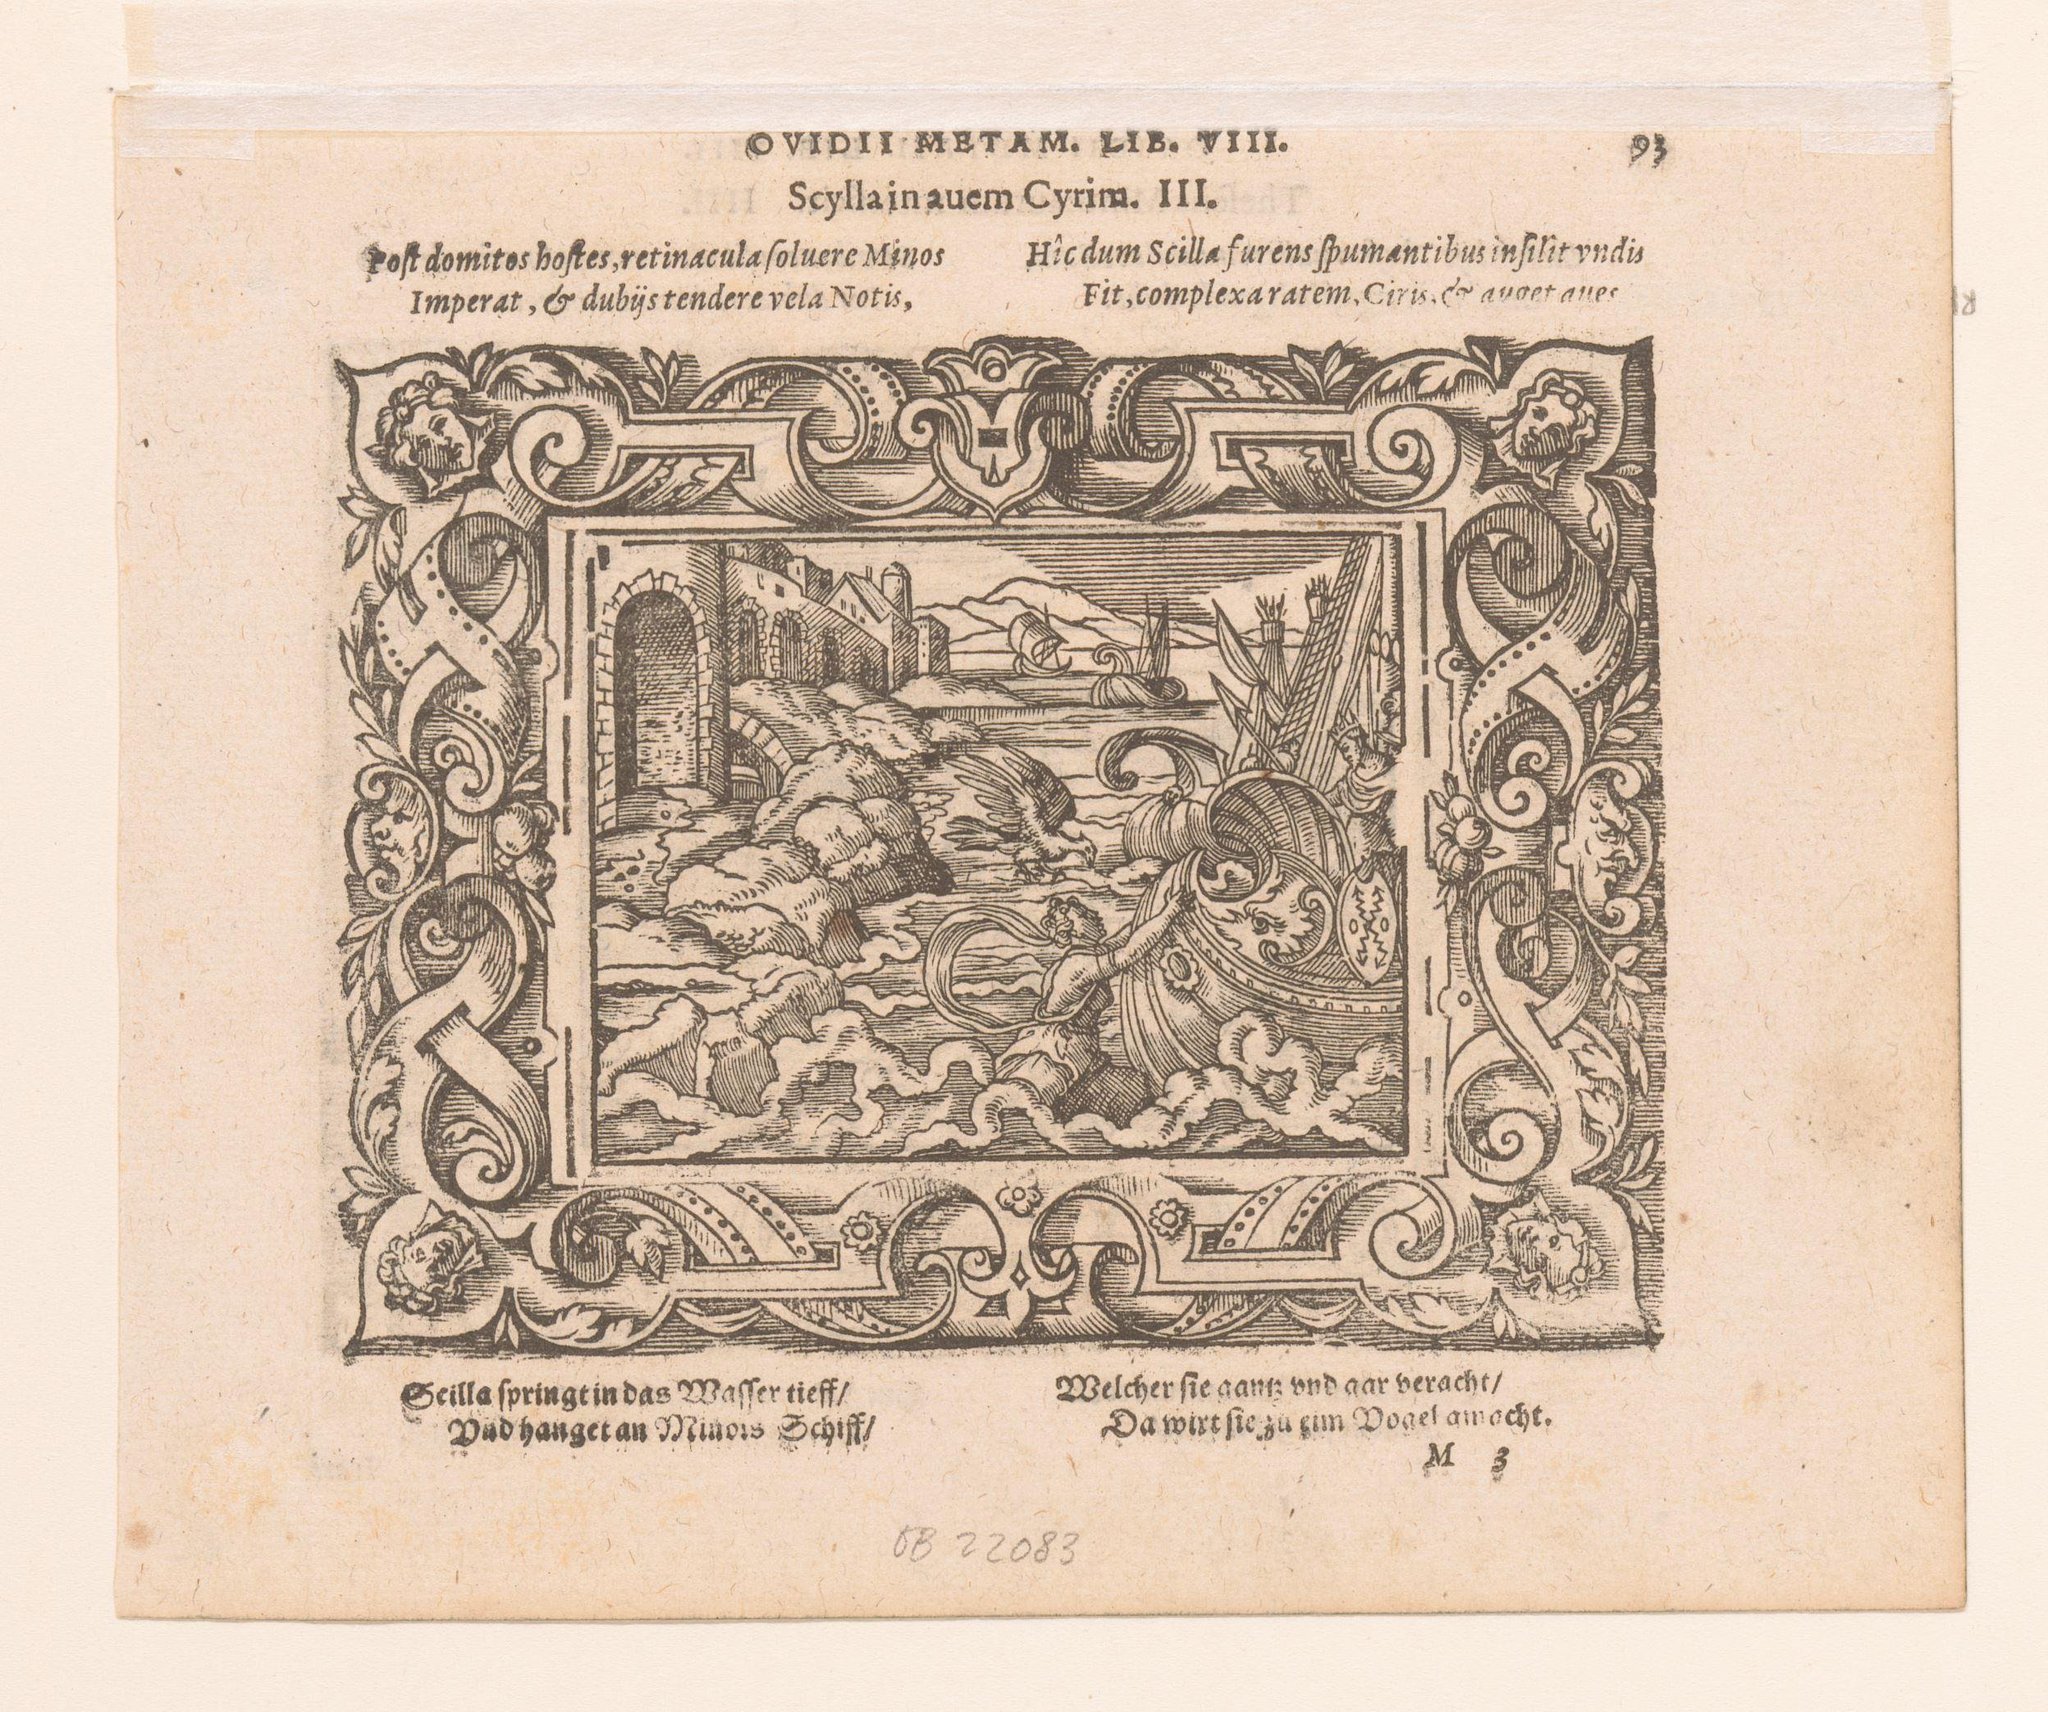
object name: print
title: Scylla in avem Cyrim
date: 1569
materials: paper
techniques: letterpress printing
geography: nuremberg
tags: scylla changed into a lark: when falling from minos' boat (or when throwing herself into the sea), scylla, daughter of nisus, is changed into a lark; she is then pursued by the hawk into which her father was transformed (ovid, metamorphoses viii 145), scrollwork, strapwork ~ ornament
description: Illustratie bij de Metamorfosen van Ovidius, afkomstig uit de publicatie: Posthius, Johannes. Tetrasticha in Ovidii metam. Frankfurt am Main: Georg Rab en Sigmund Feyerabend en erven Weigand Han, 1569. De voorstellingen en ornamentranden van deze boekillustraties zijn van twee aparte blokken gedrukt. Beide werden afzonderlijk van elkaar ook gebruikt voor andere publicaties, en de ornamentranden werden eveneens binnen deze publicatie meerdere keren gebruikt.